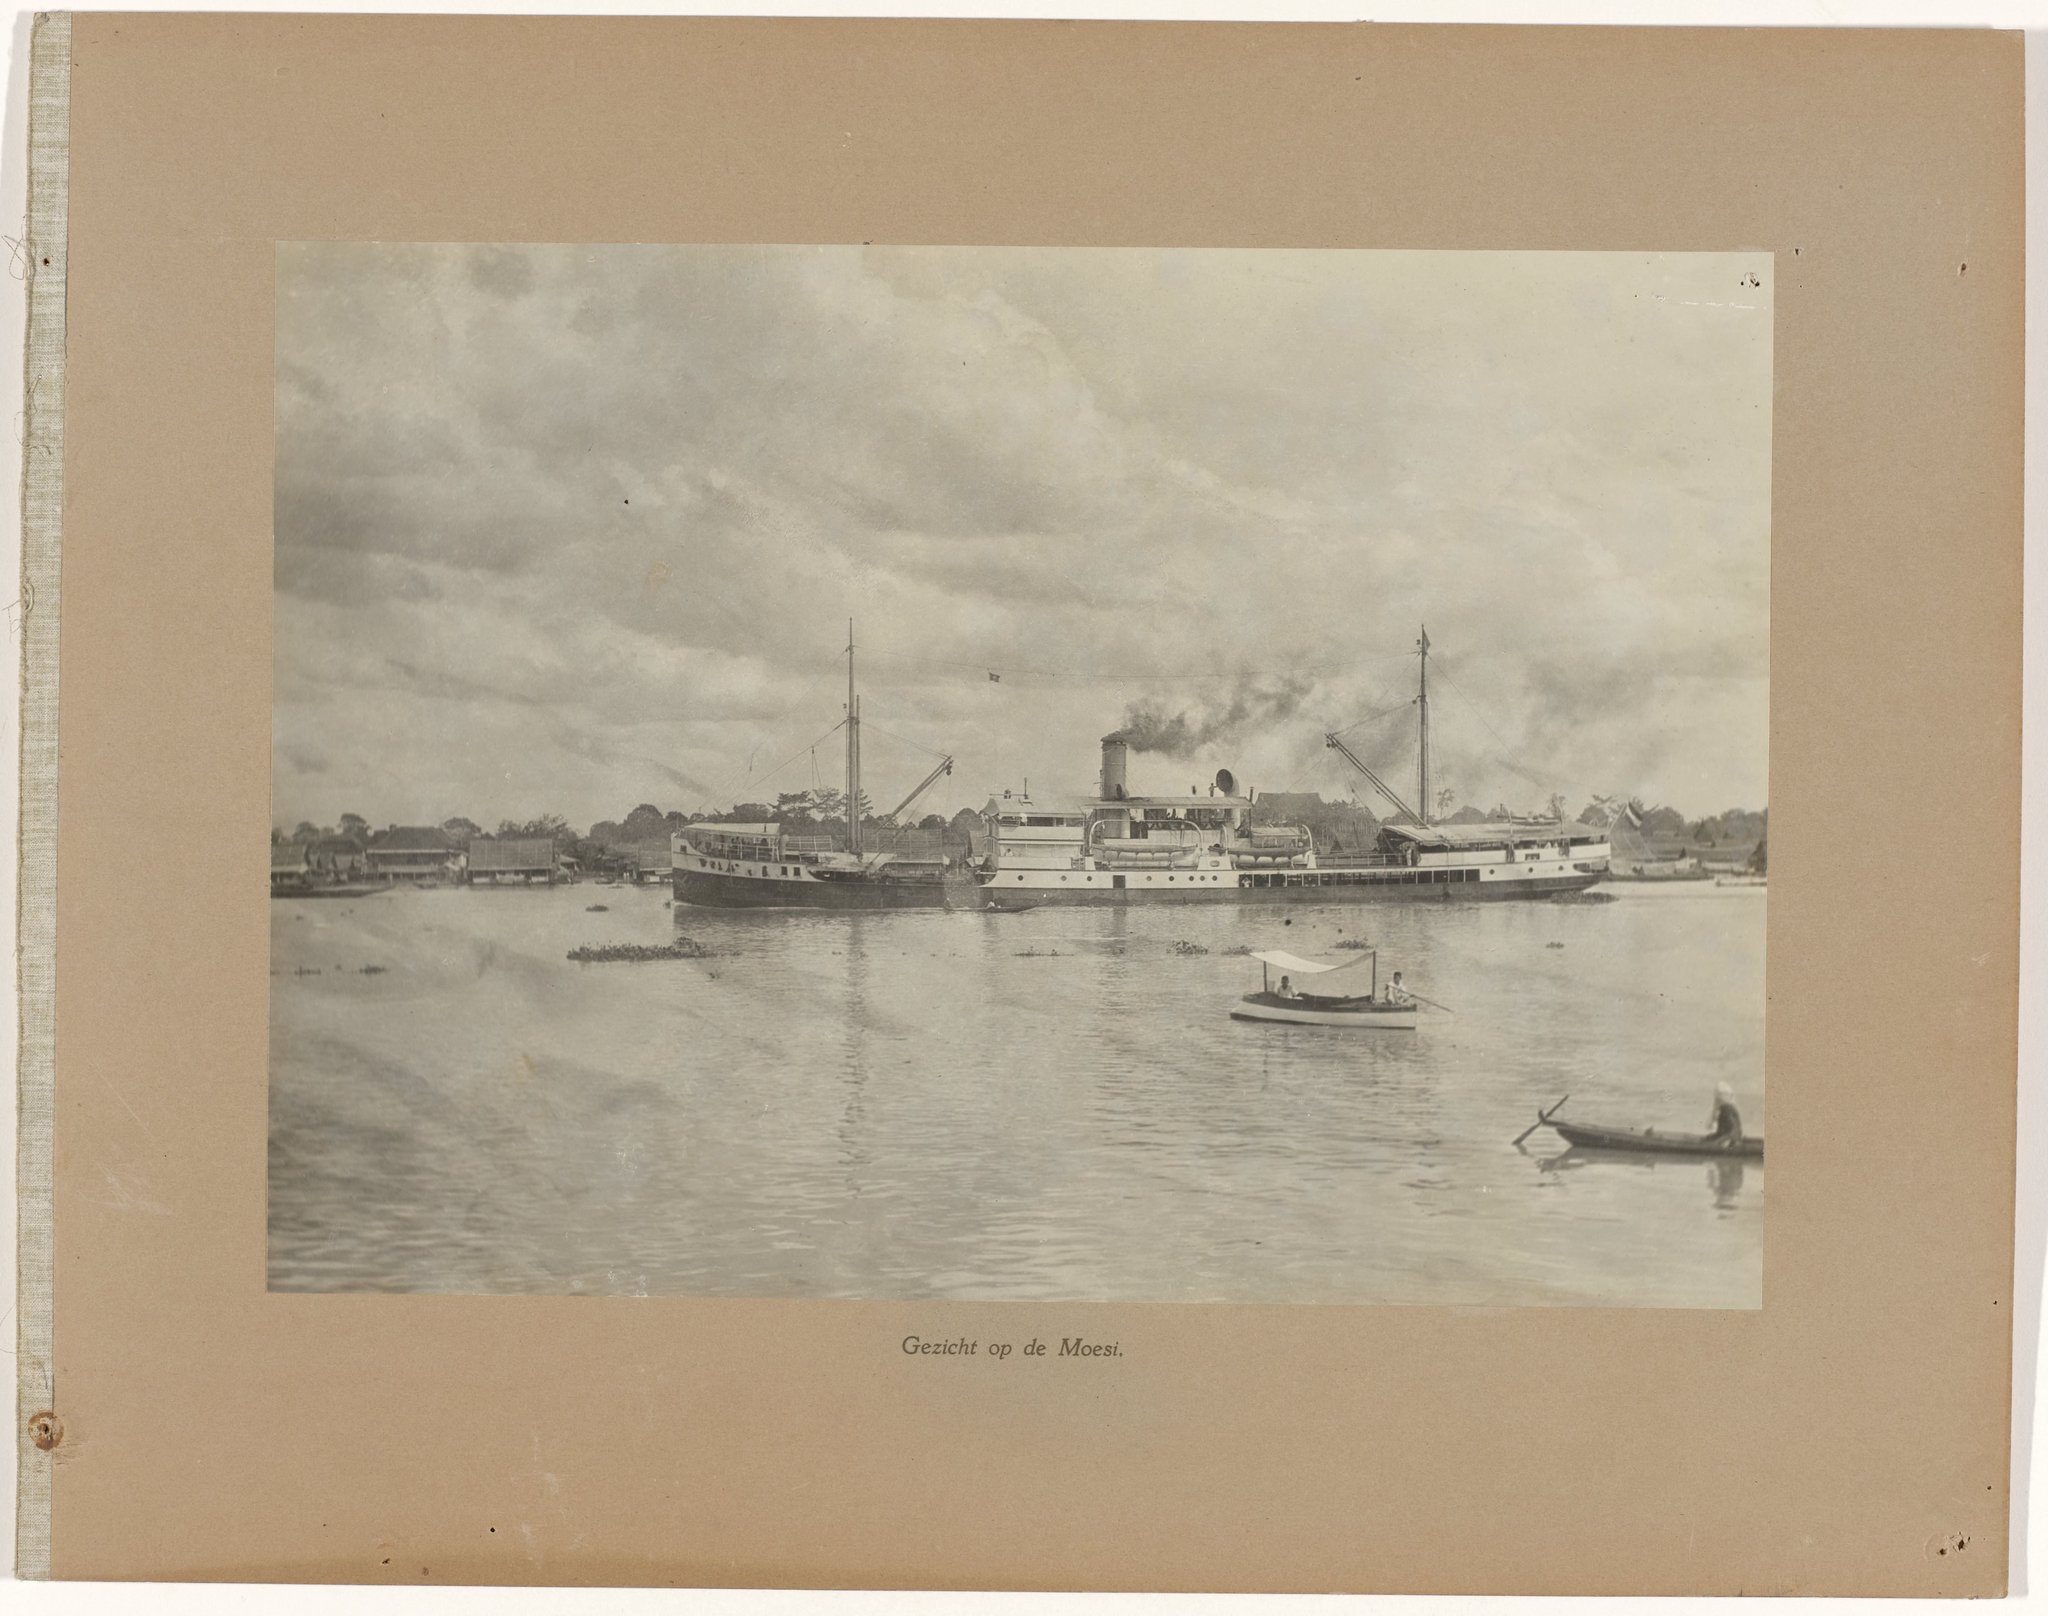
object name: photograph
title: Gezicht op de Moesi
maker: Anonymous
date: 1921-1922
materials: photographic support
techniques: gelatin silver print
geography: bukit asam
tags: colonial system, anthracite, hard coal, river, opencast mine; strip mining (+ coal), steamship, motorship, sumatra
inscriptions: inscription: ‘Gezicht op de Moesi.’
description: Gezicht op de rivier Air Musi (Moesi) met een stoomschip, mogelijk de veerboot. Onderdeel van het losbladige fotoalbum aangeboden door het personeel van de Boekit-Asam Steenkolenmijnen op Sumatra aan de scheidende Ingenieur-Directeur H. Tromp op 7 januari 1922.